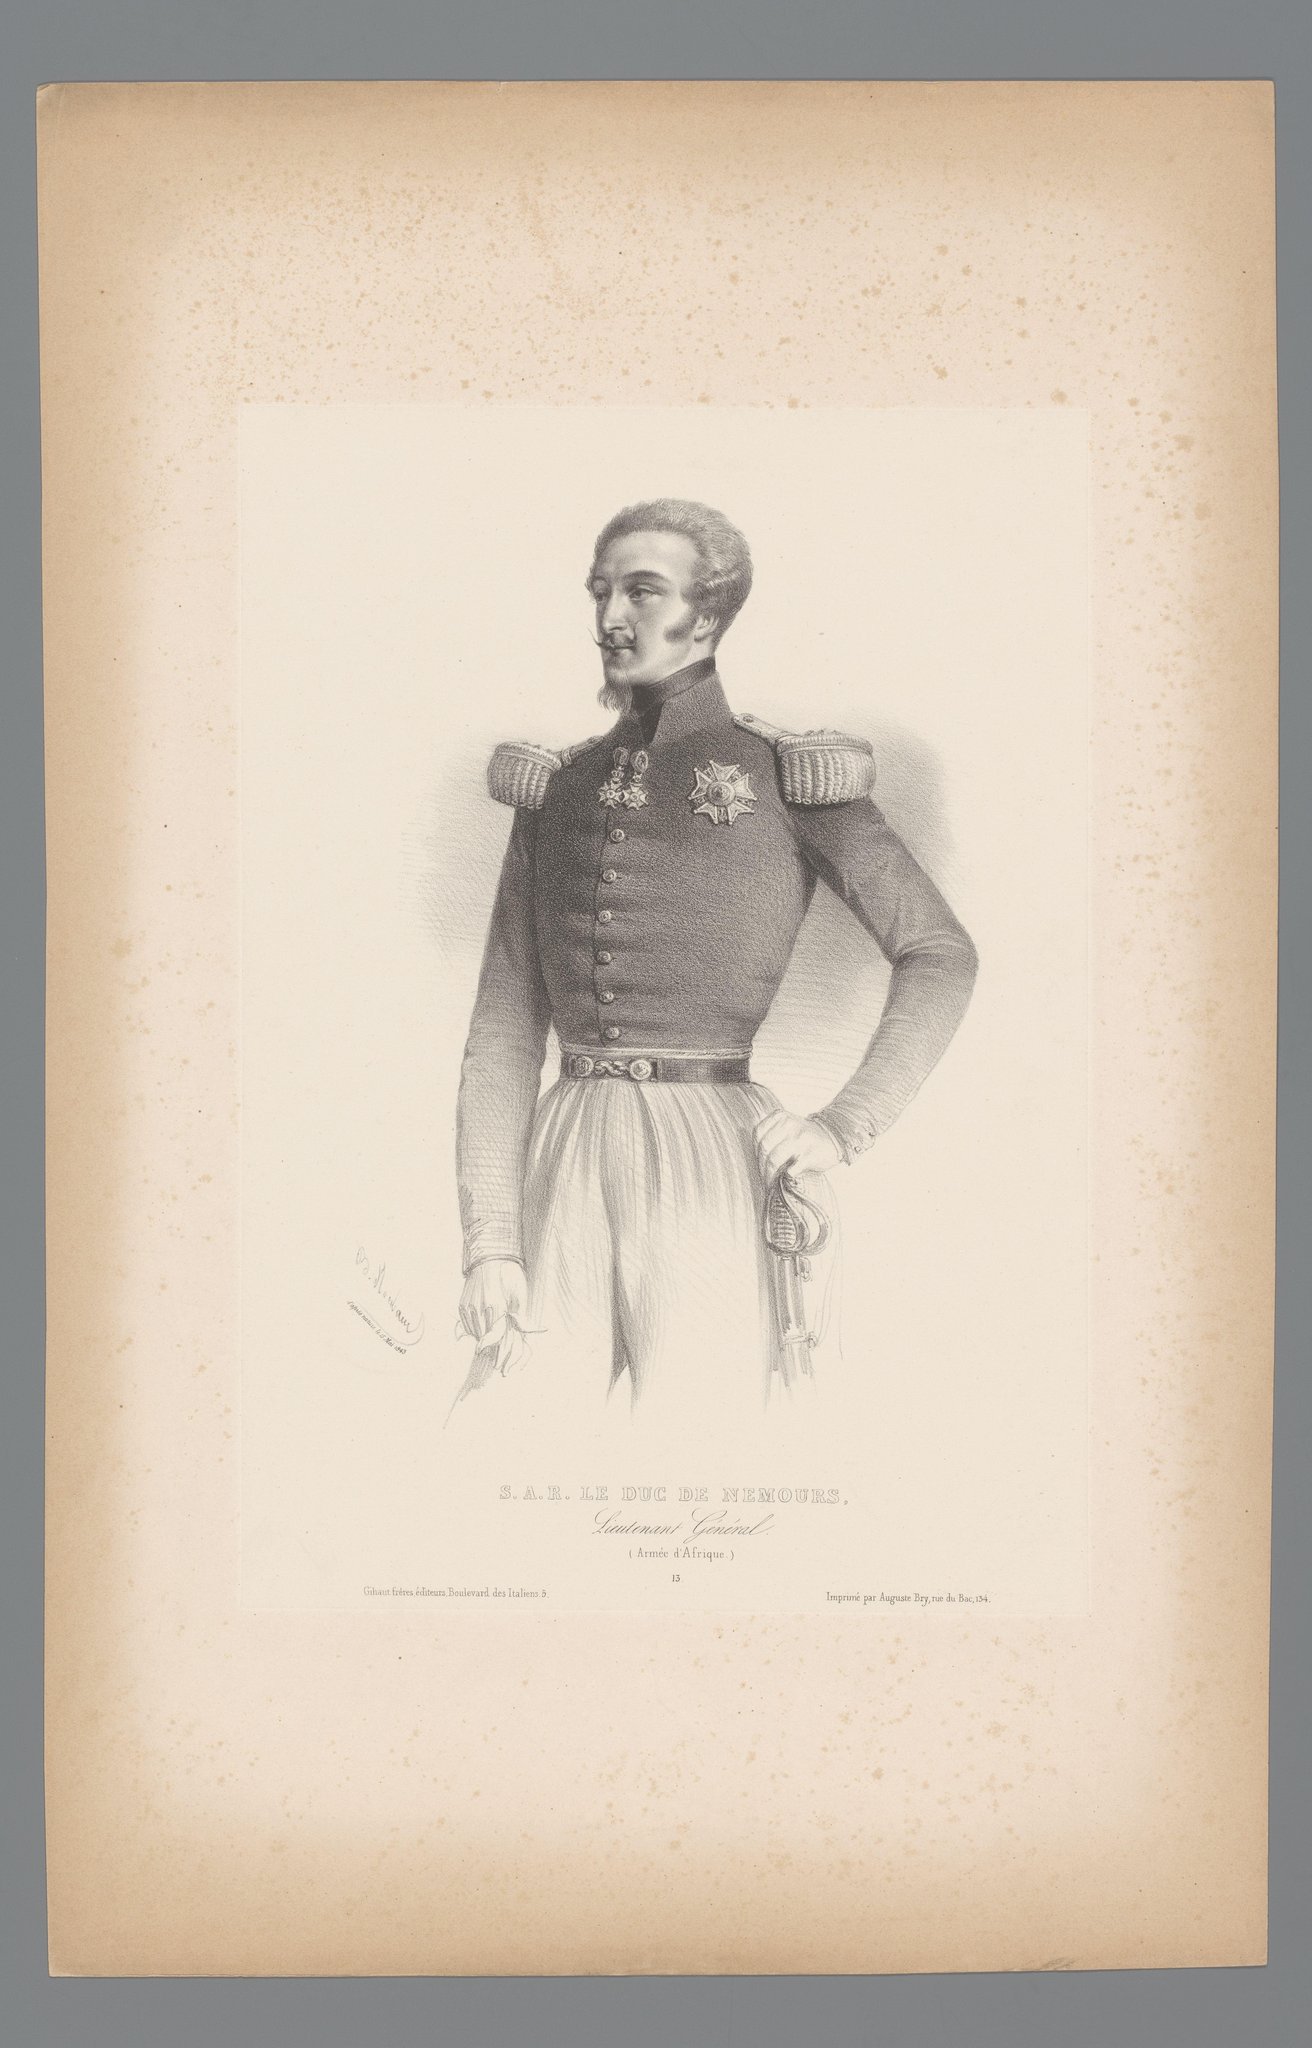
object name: print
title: S.A.R. le duc de Nemours, lieutenant général. (Armée d'Afrique.)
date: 1843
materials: paper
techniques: lithograph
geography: paris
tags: commander-in-chief, general, marshal, historical persons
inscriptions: collector's mark: Lugt 2228